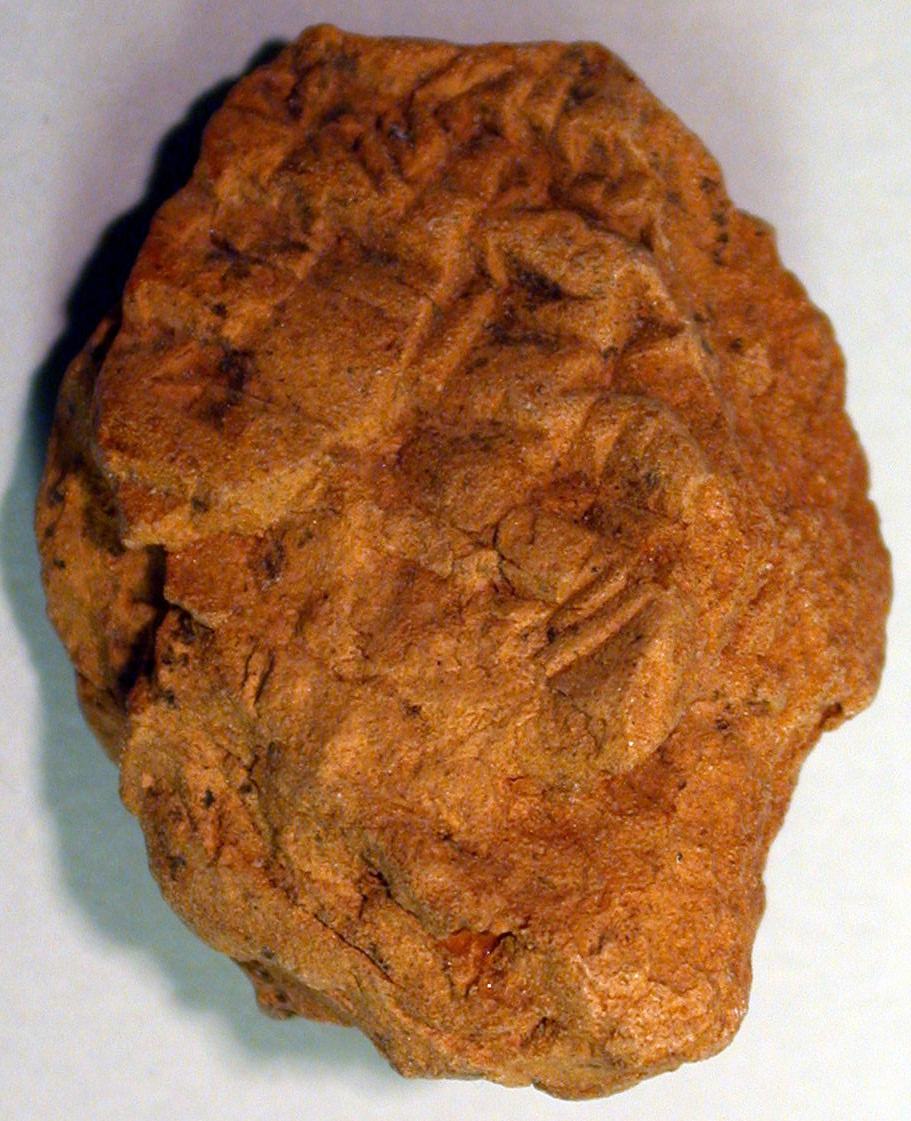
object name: cuneiform tablet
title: Cuneiform tablet: unidentified fragment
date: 333-1 BCE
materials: clay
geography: mesopotamia